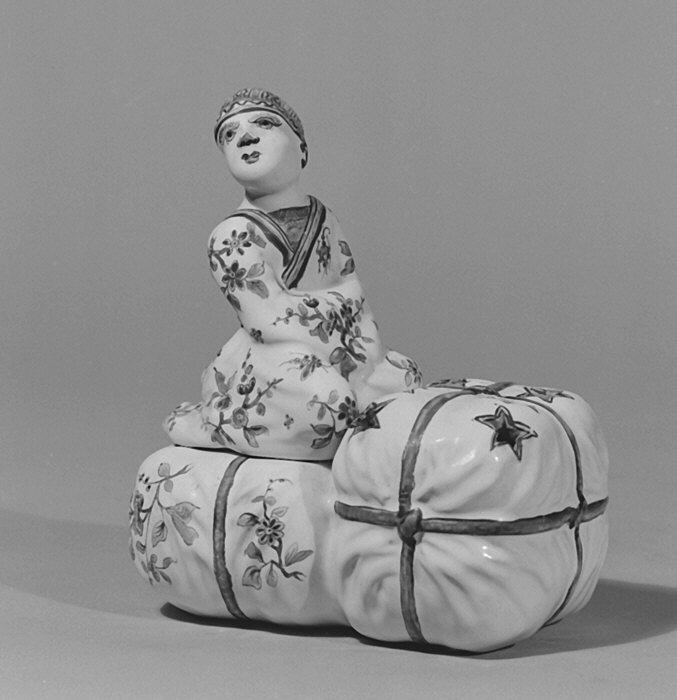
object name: box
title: Figural box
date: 1740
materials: faience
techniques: glazing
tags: human figures